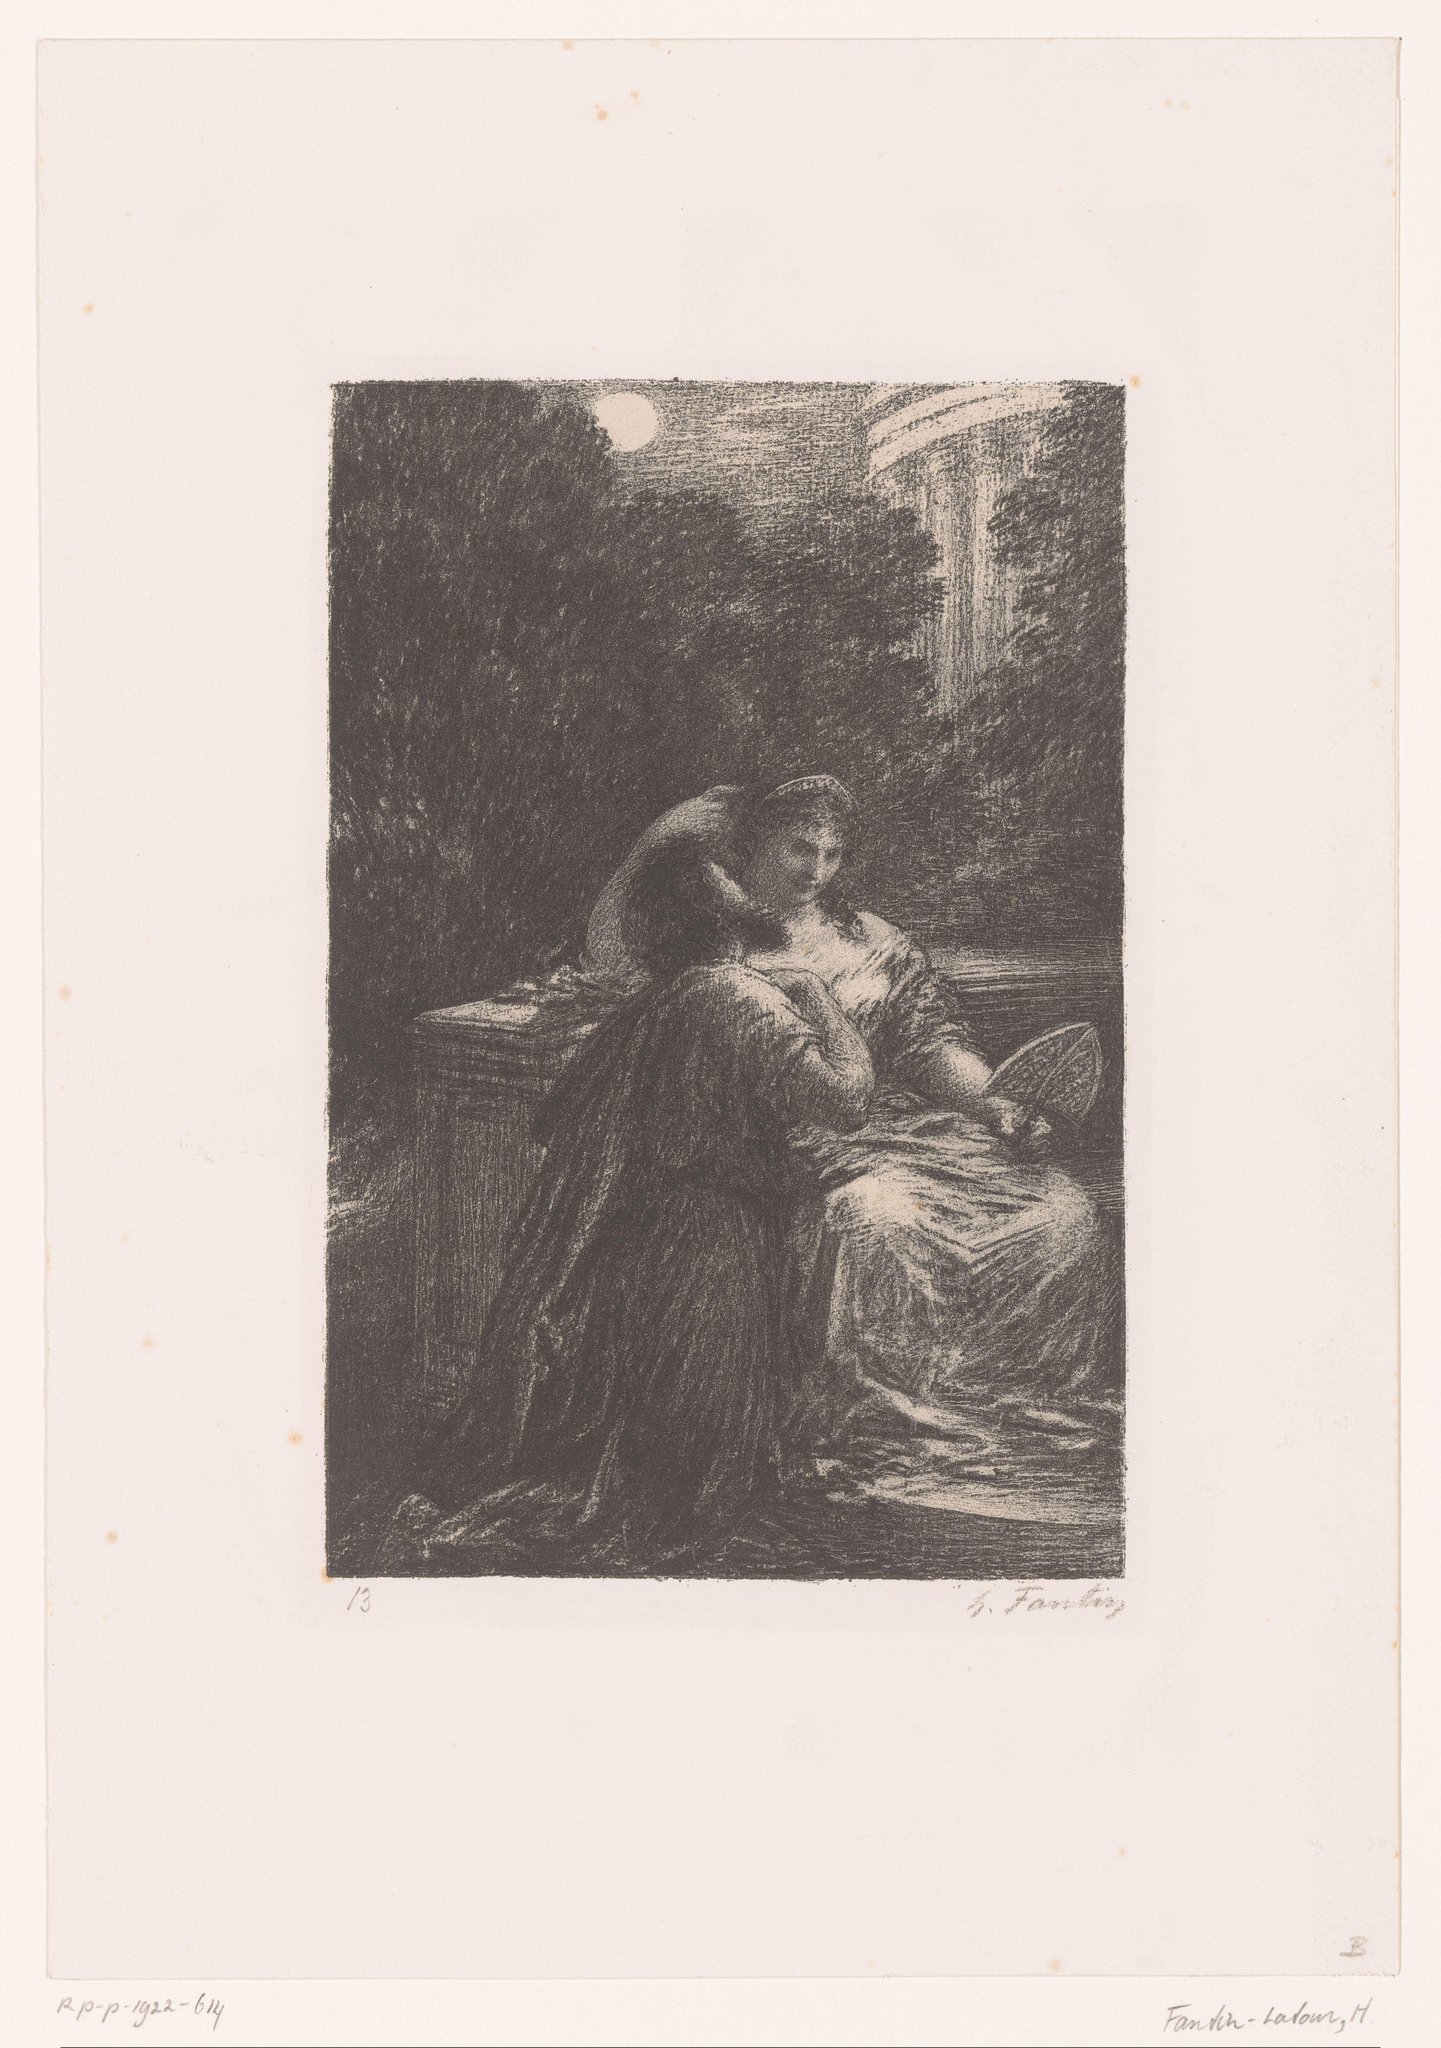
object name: print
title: Leven en werken van Hector Berlioz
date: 1888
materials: paper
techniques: lithography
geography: paris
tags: moonlight, (story of) dido - love-affairs, love-affairs of aeneas, lovers; courting, flirting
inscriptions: collector's mark: Lugt 2228a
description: Prent gebruikt voor: A. Jullien, Hector Berlioz: sa vie et ses œuvres, Parijs 1888, p. 290-291. Scène uit Berlioz' opera Les Troyens (Les Troyes à Carthage, akte III).